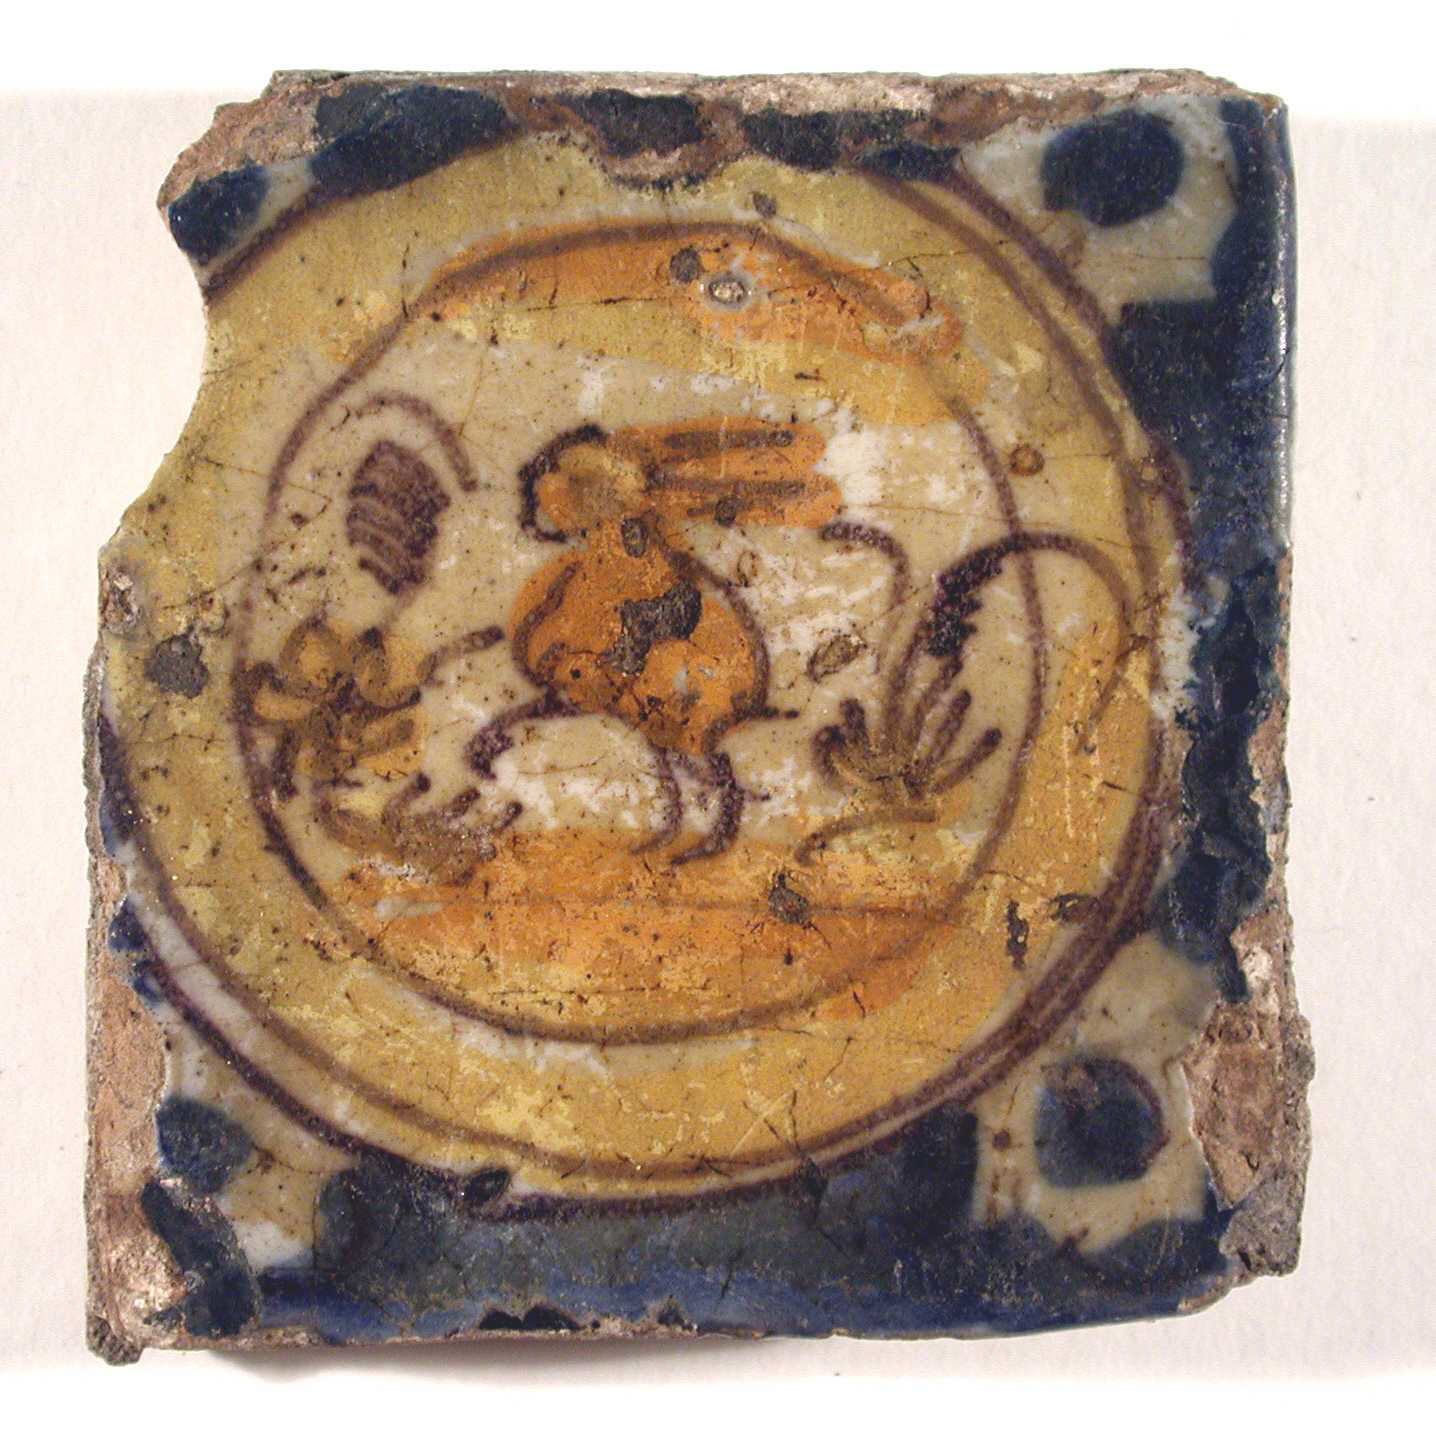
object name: tile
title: Tiles (3)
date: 1501-1700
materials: earthenware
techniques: glazing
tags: lions,rabbits